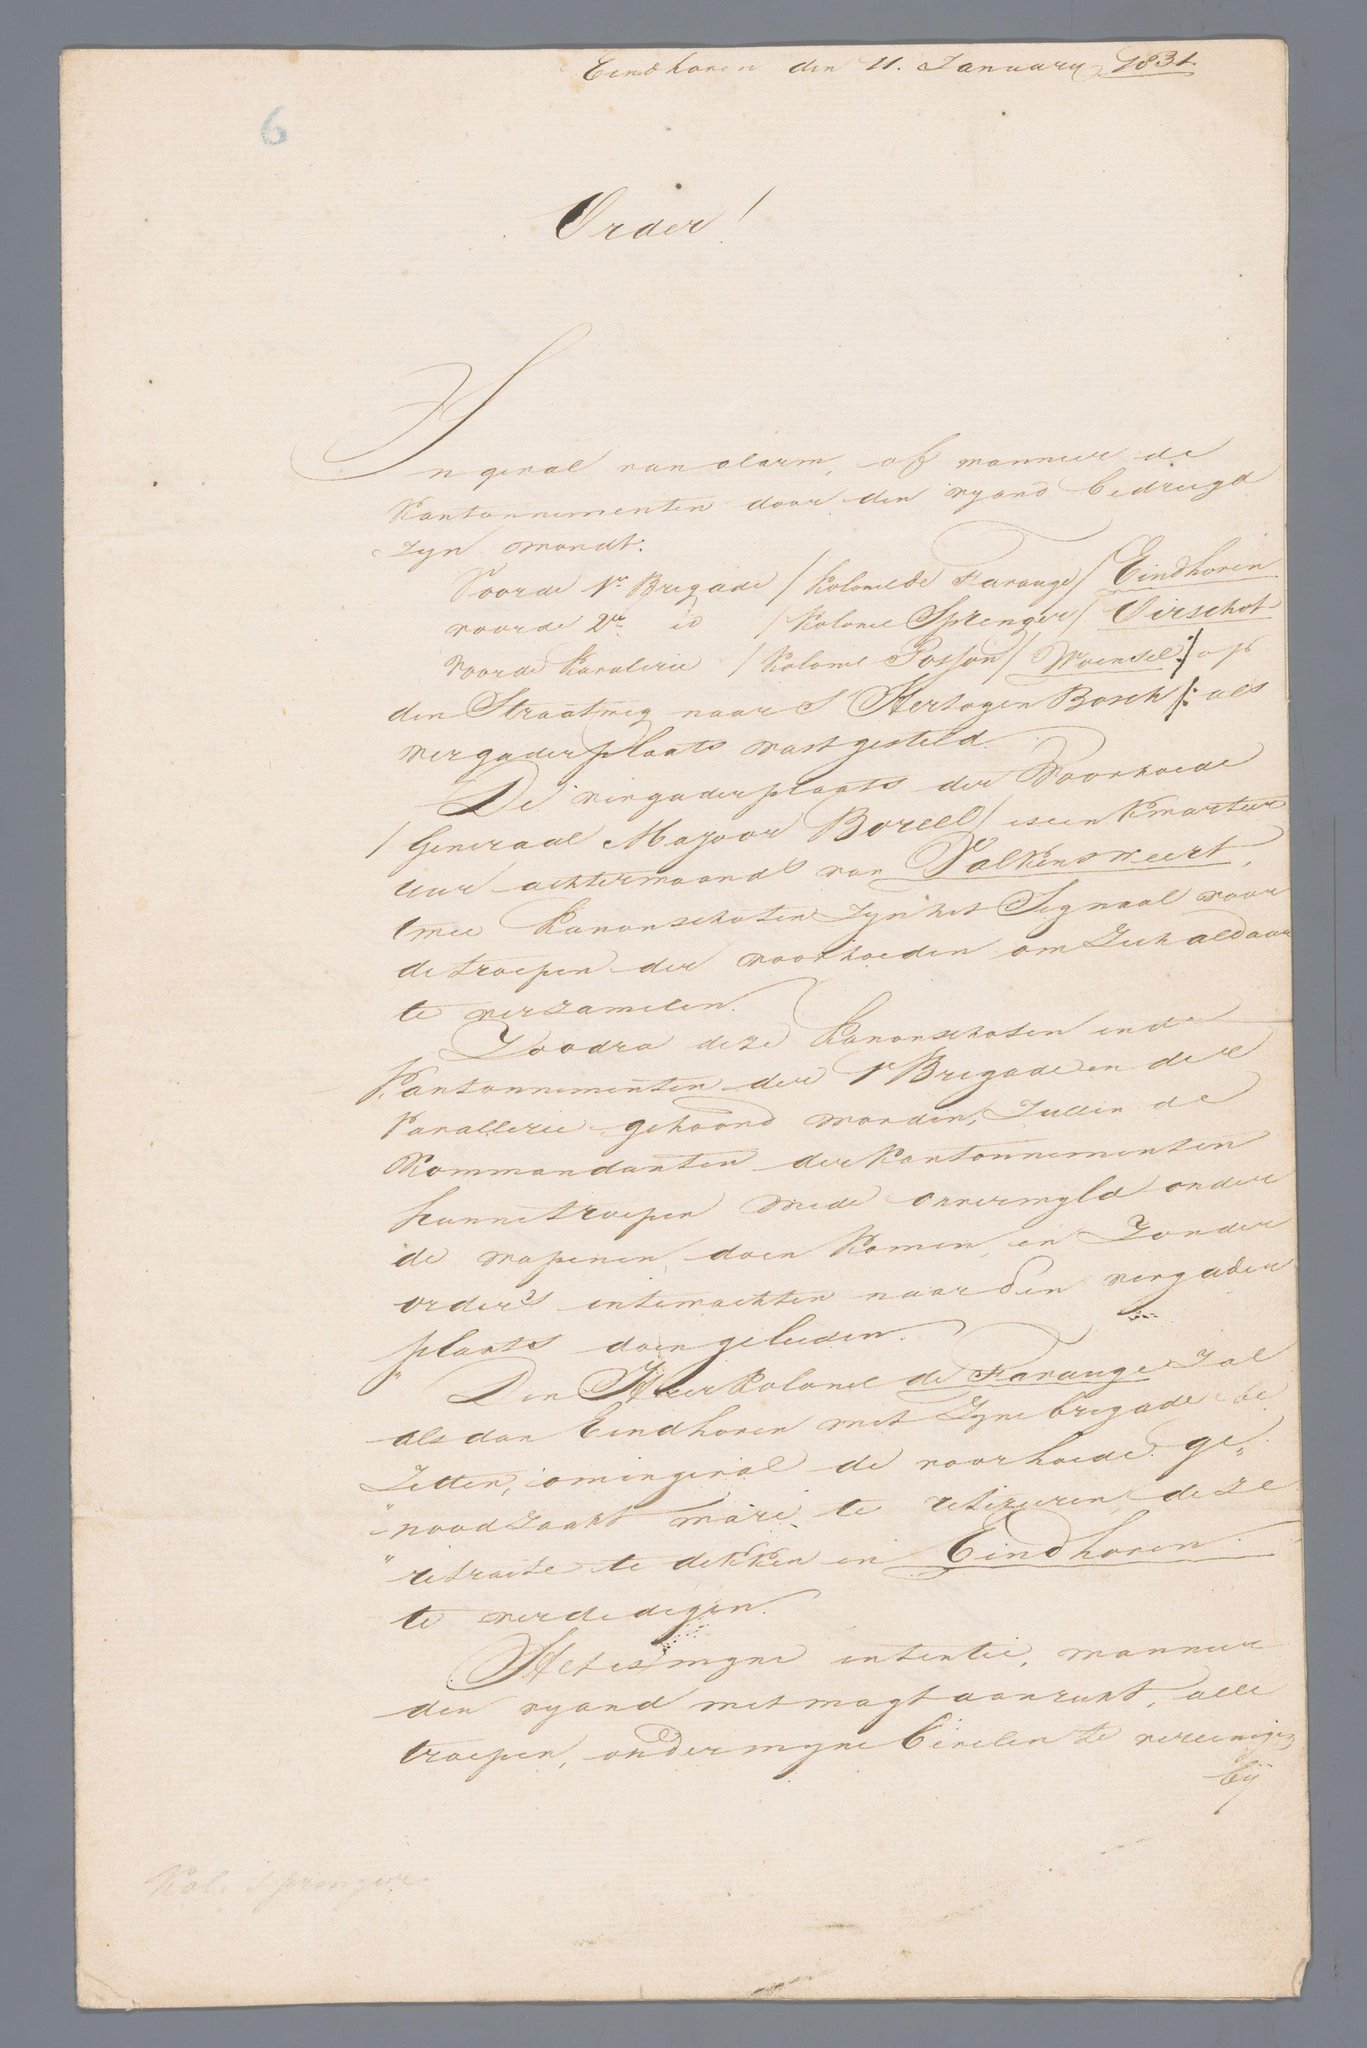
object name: order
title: Order!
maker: karel bernhard (hertog van saksen-weimar-eisenach)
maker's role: generaal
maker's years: 1792-1862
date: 1831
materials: ink, paper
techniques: writing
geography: eindhoven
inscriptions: date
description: Dubbelgevouwen vel papier, op 3 pp beschreven, legerorder van Saxen Weimar, generaal-majoor. Gedateerd; p. 1, r.b.: den 11 Januarij 1831. Gesigneerd op p.3.